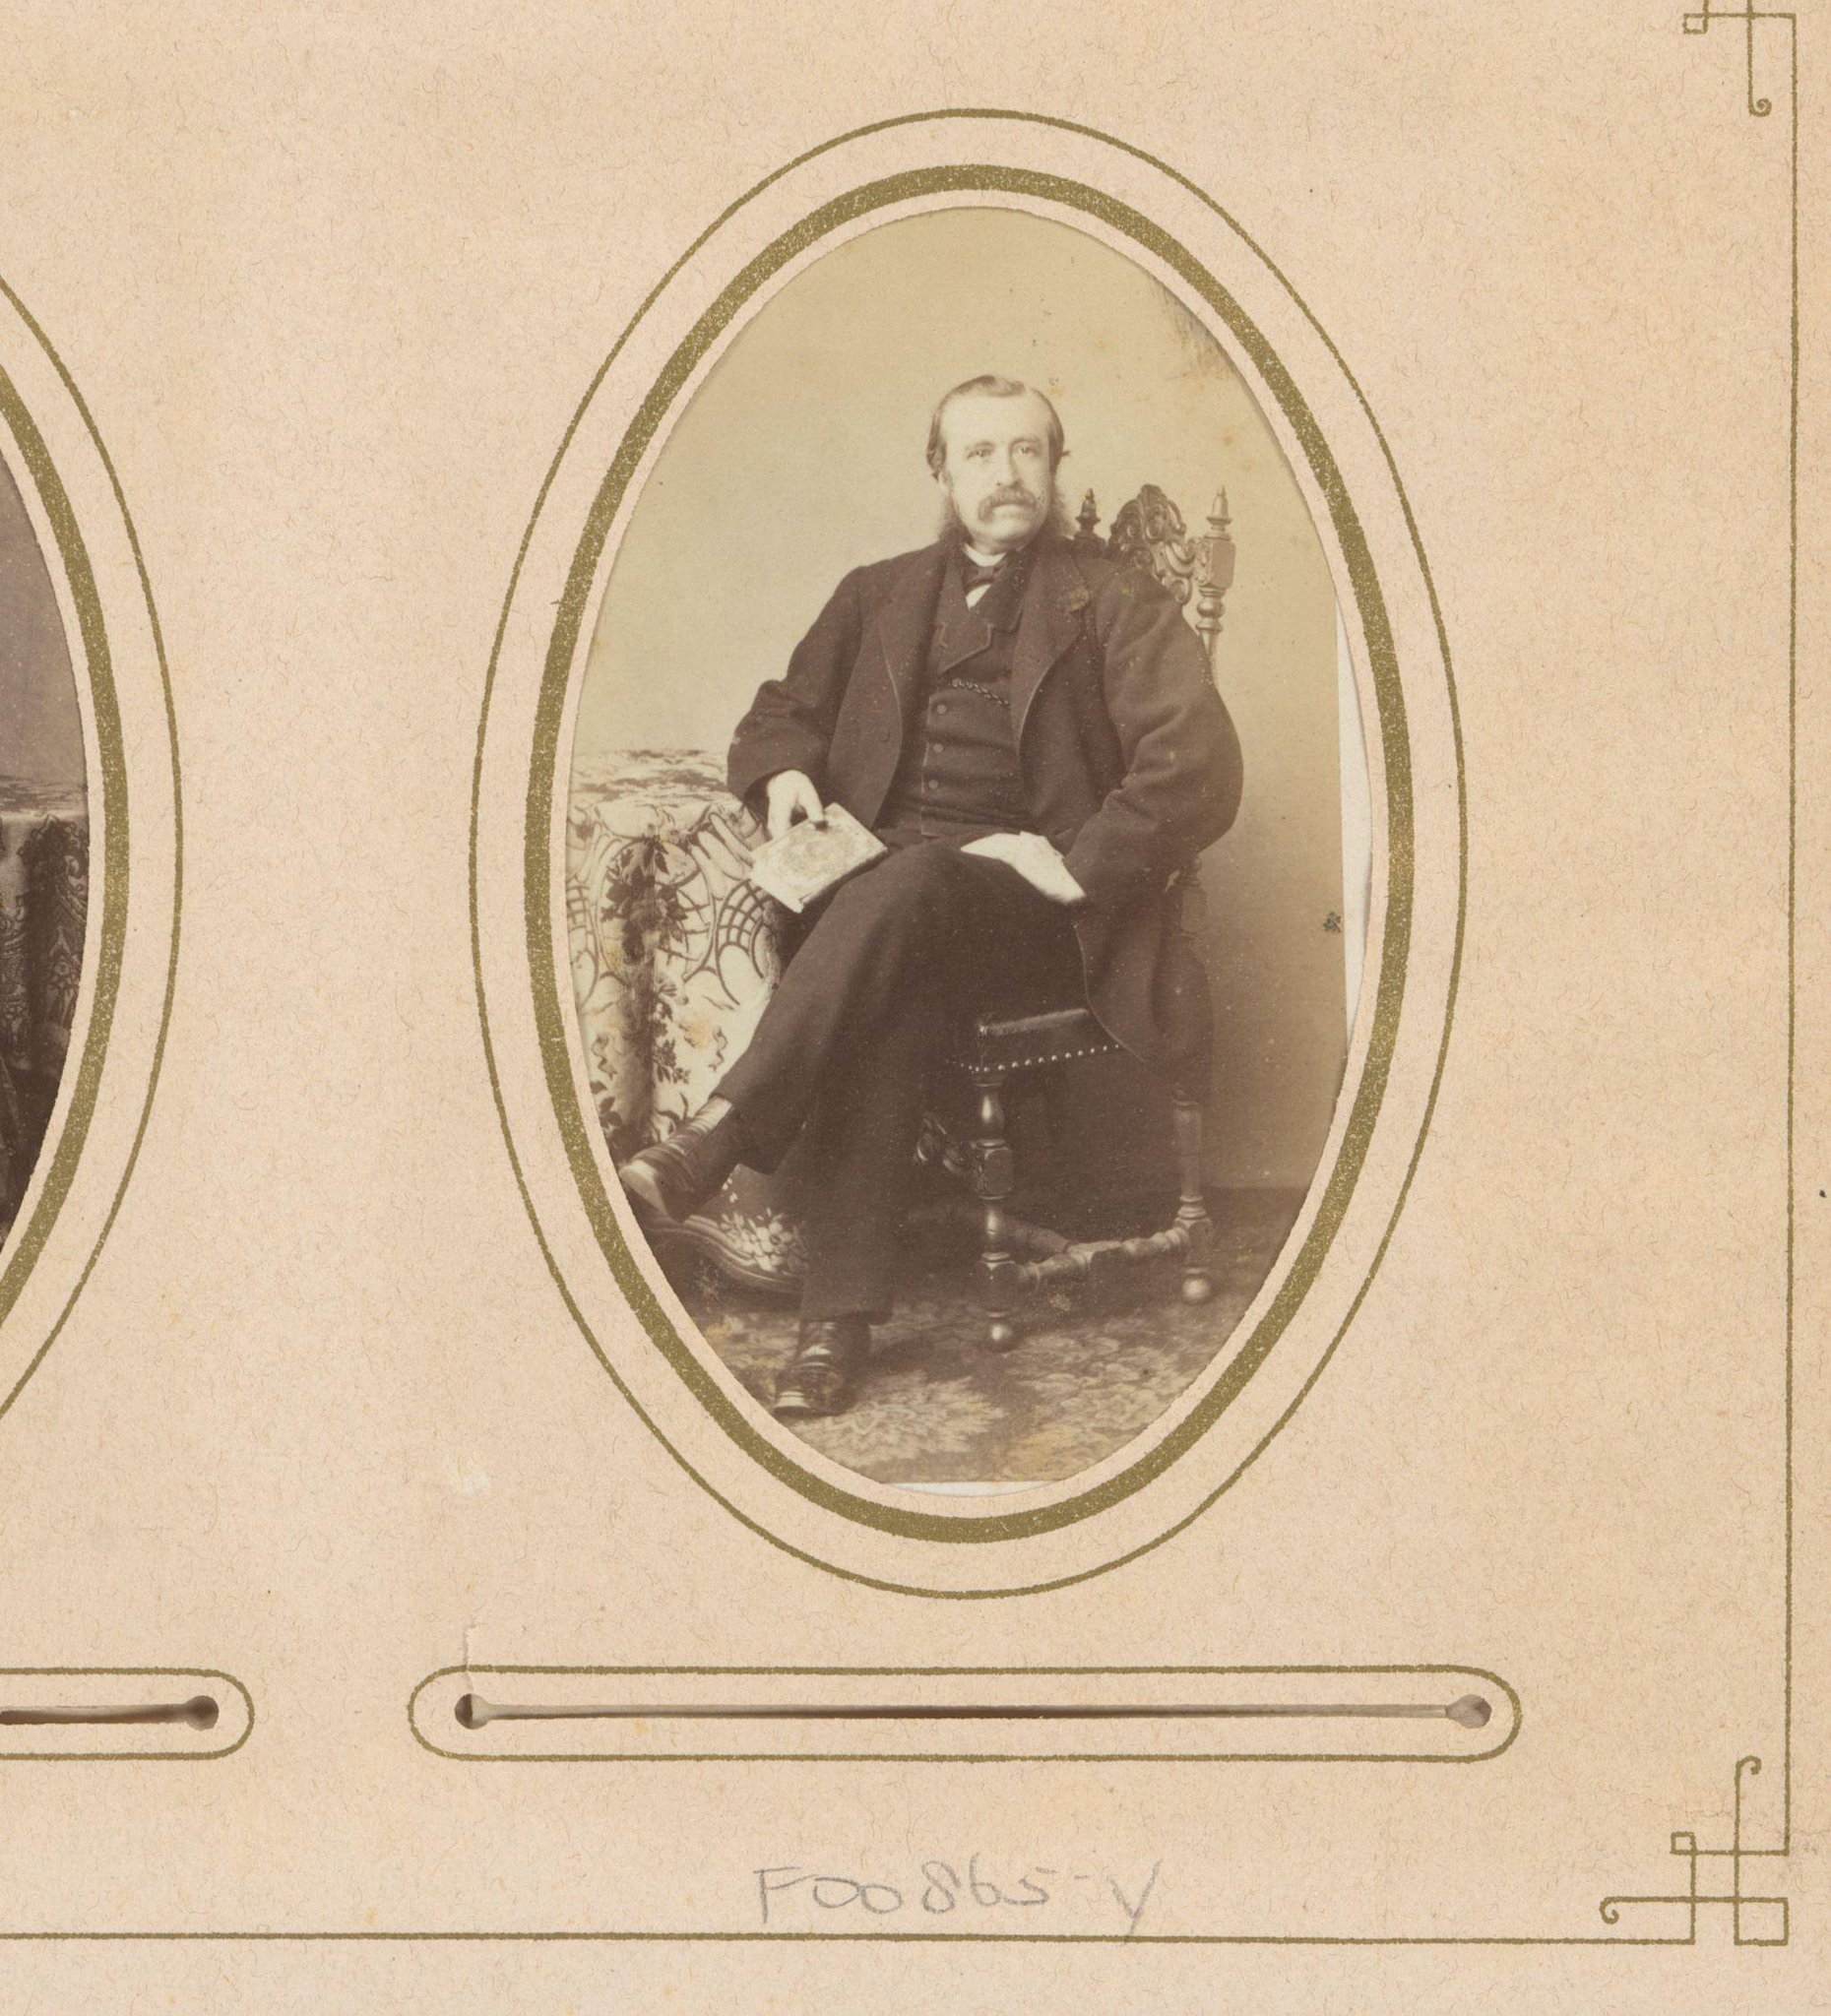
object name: photograph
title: Portret van een man met boek in de hand, zittend aan een tafel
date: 1865-1870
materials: cardboard, photographic support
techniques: albumen print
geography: brussels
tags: sitting figure, historical persons, table, book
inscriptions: inscription: ‘ATELIER DE PHOTOGRAPHIE/ BILLOTTE FRÈRES,/ 9, rue de la Reine,/ près la Place de la Monnaie,/ BRUXELLES.’